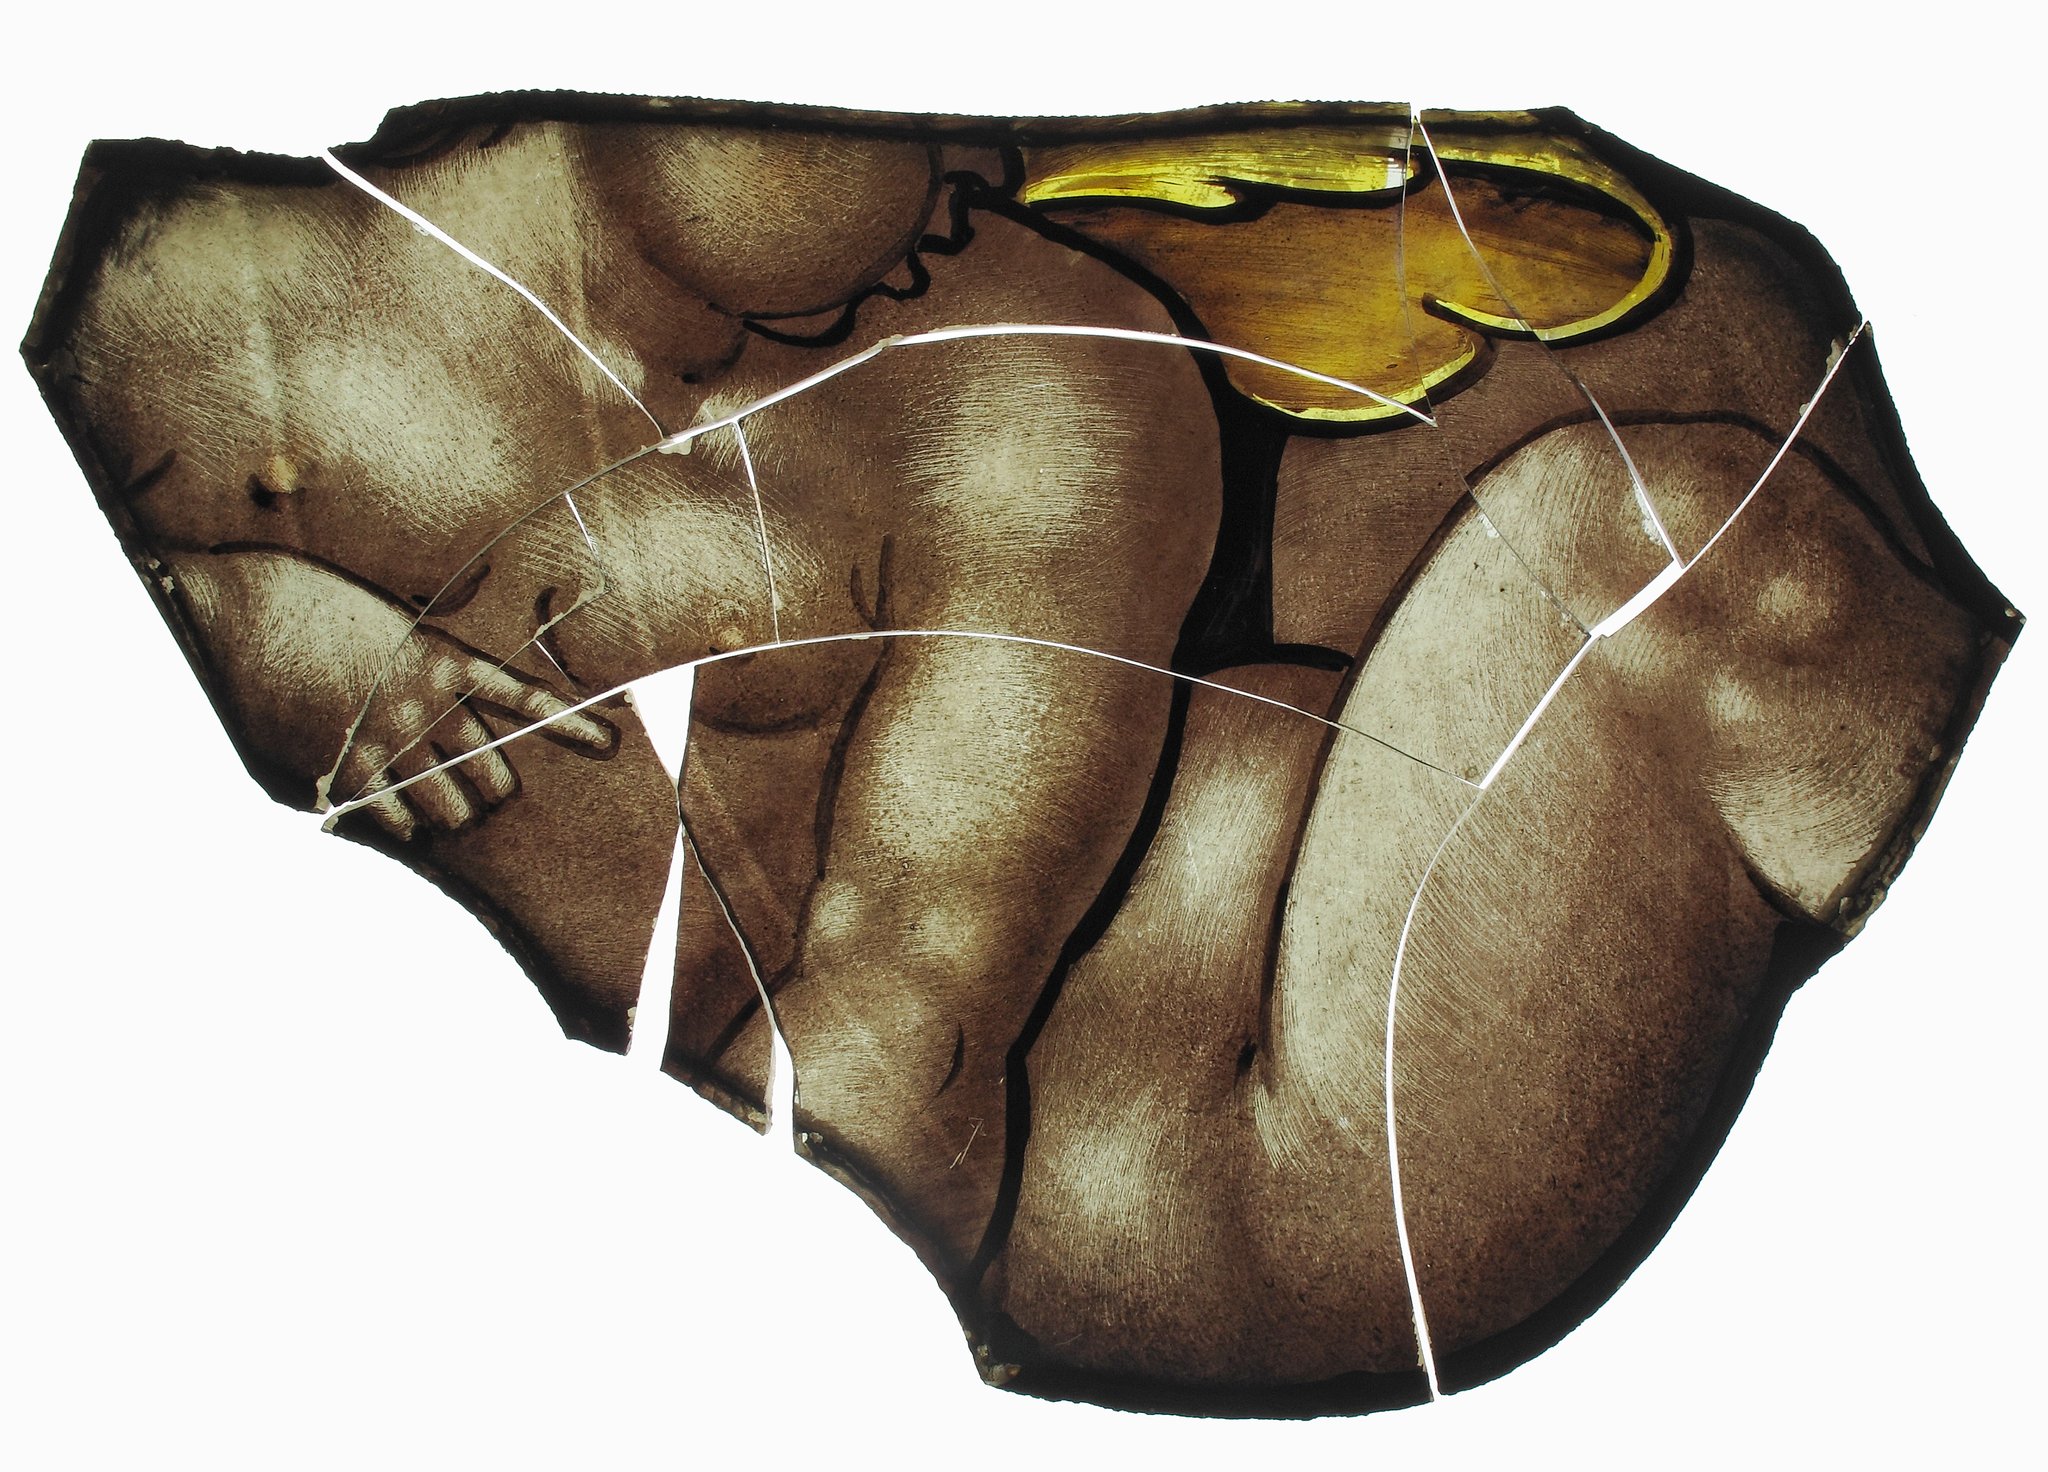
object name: fragment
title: Glass Fragment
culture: south netherlandish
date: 1501-1600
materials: glass, pigment